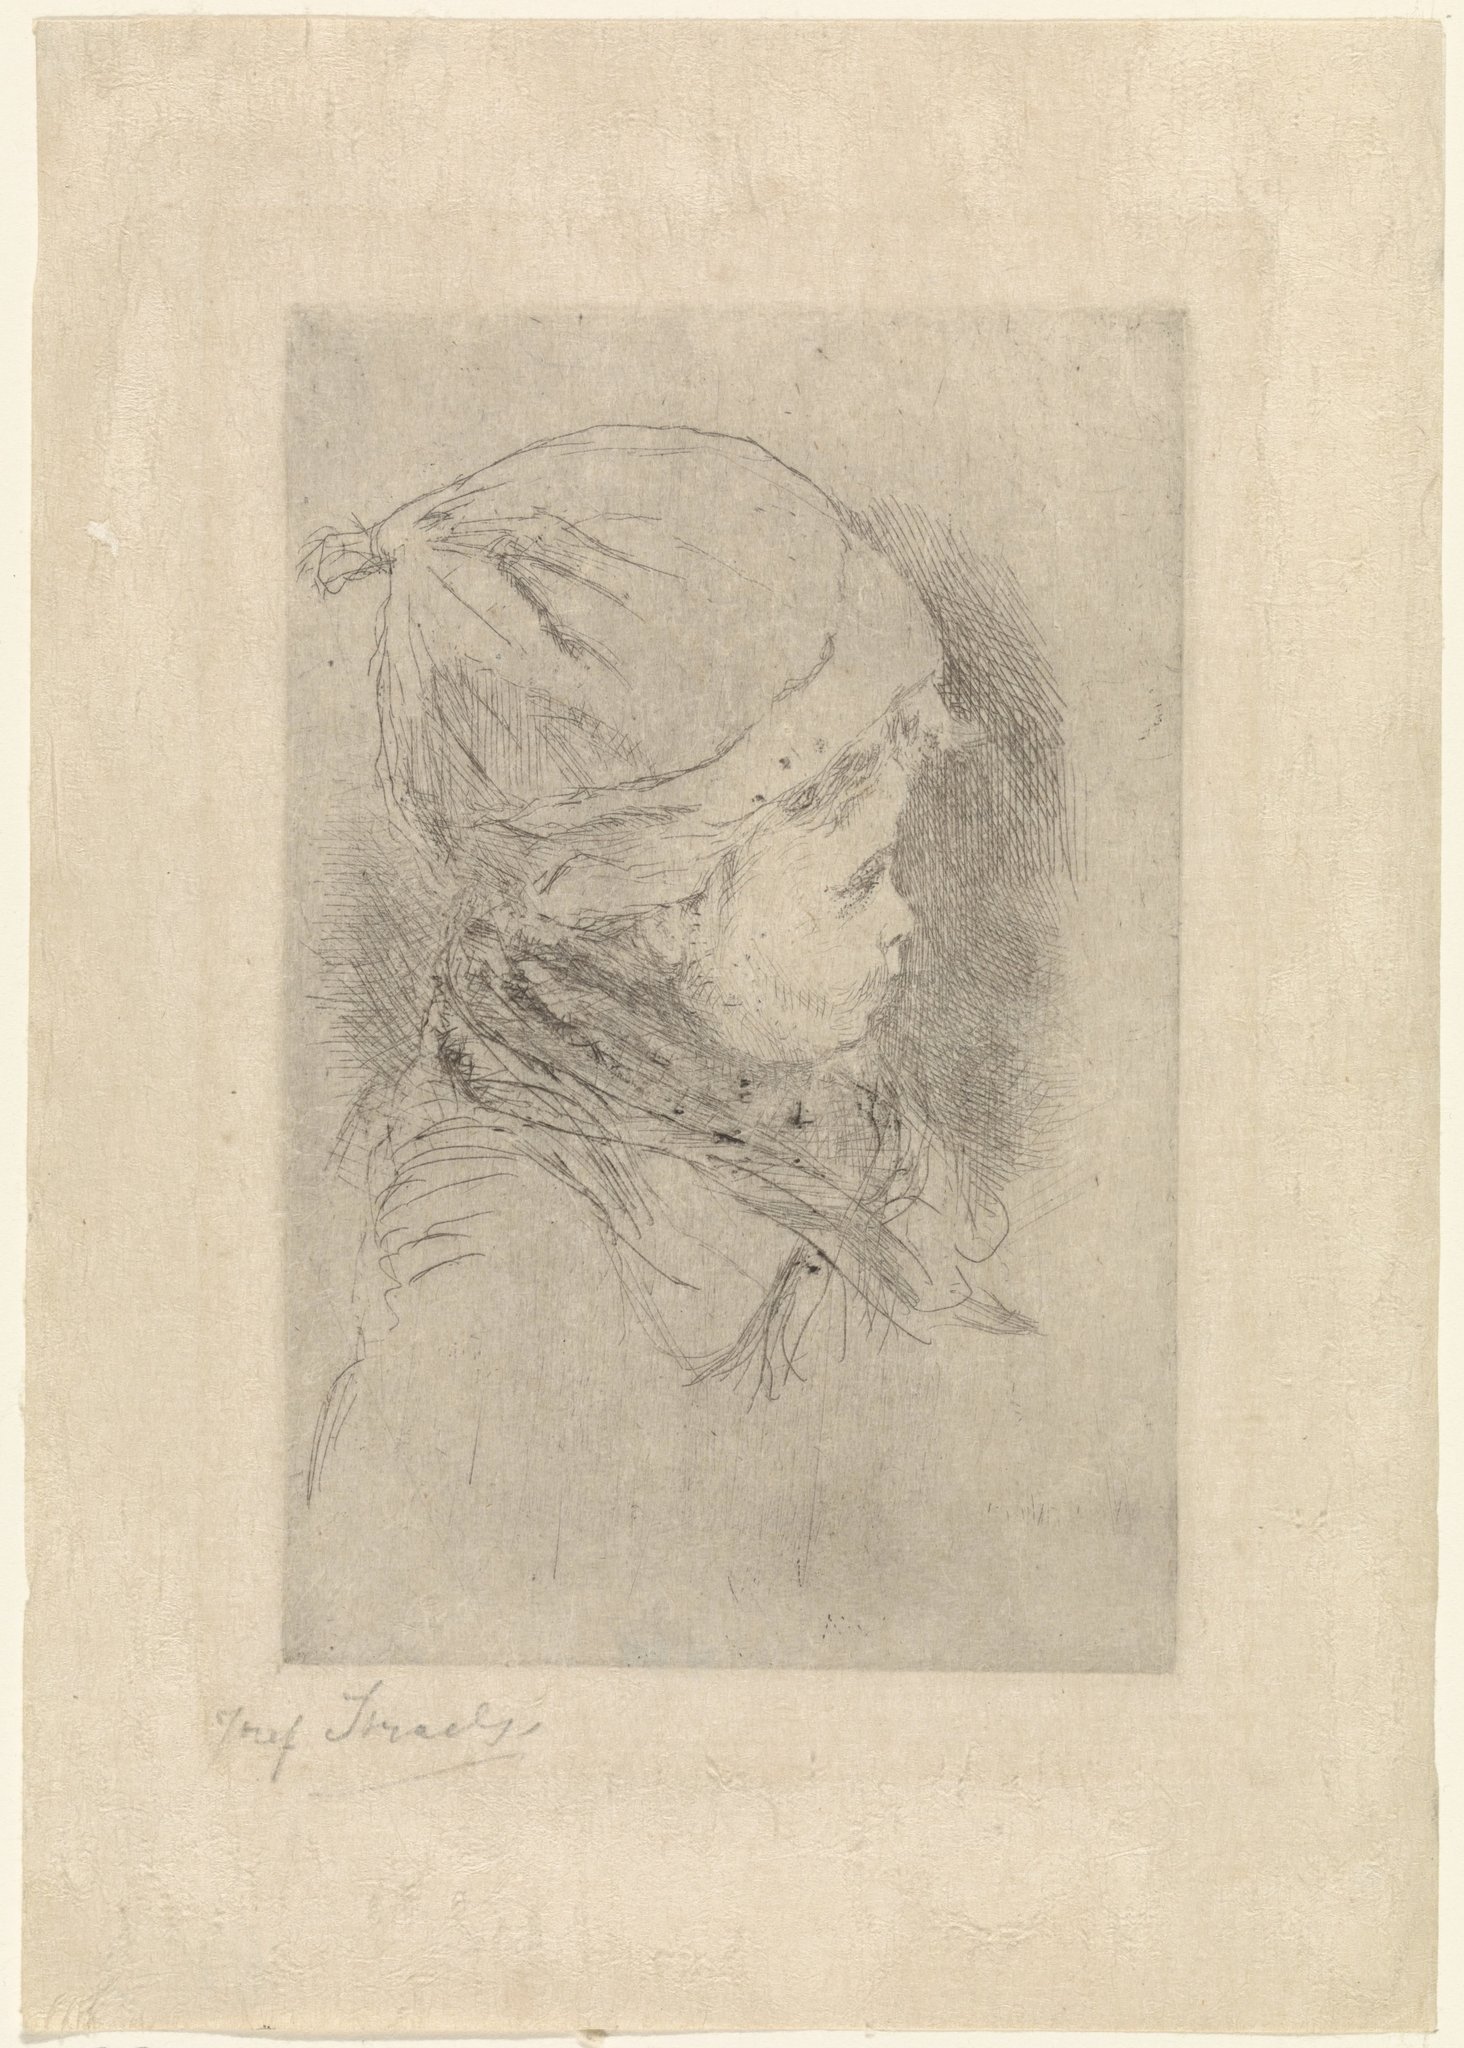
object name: print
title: Portret van Jan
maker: jozef israëls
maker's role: draughtsman, painter, print maker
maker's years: 1824-1911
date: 1835-1911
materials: paper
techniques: etching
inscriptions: collector's mark: Lugt 2228, signature: ‘Jozef Israels’